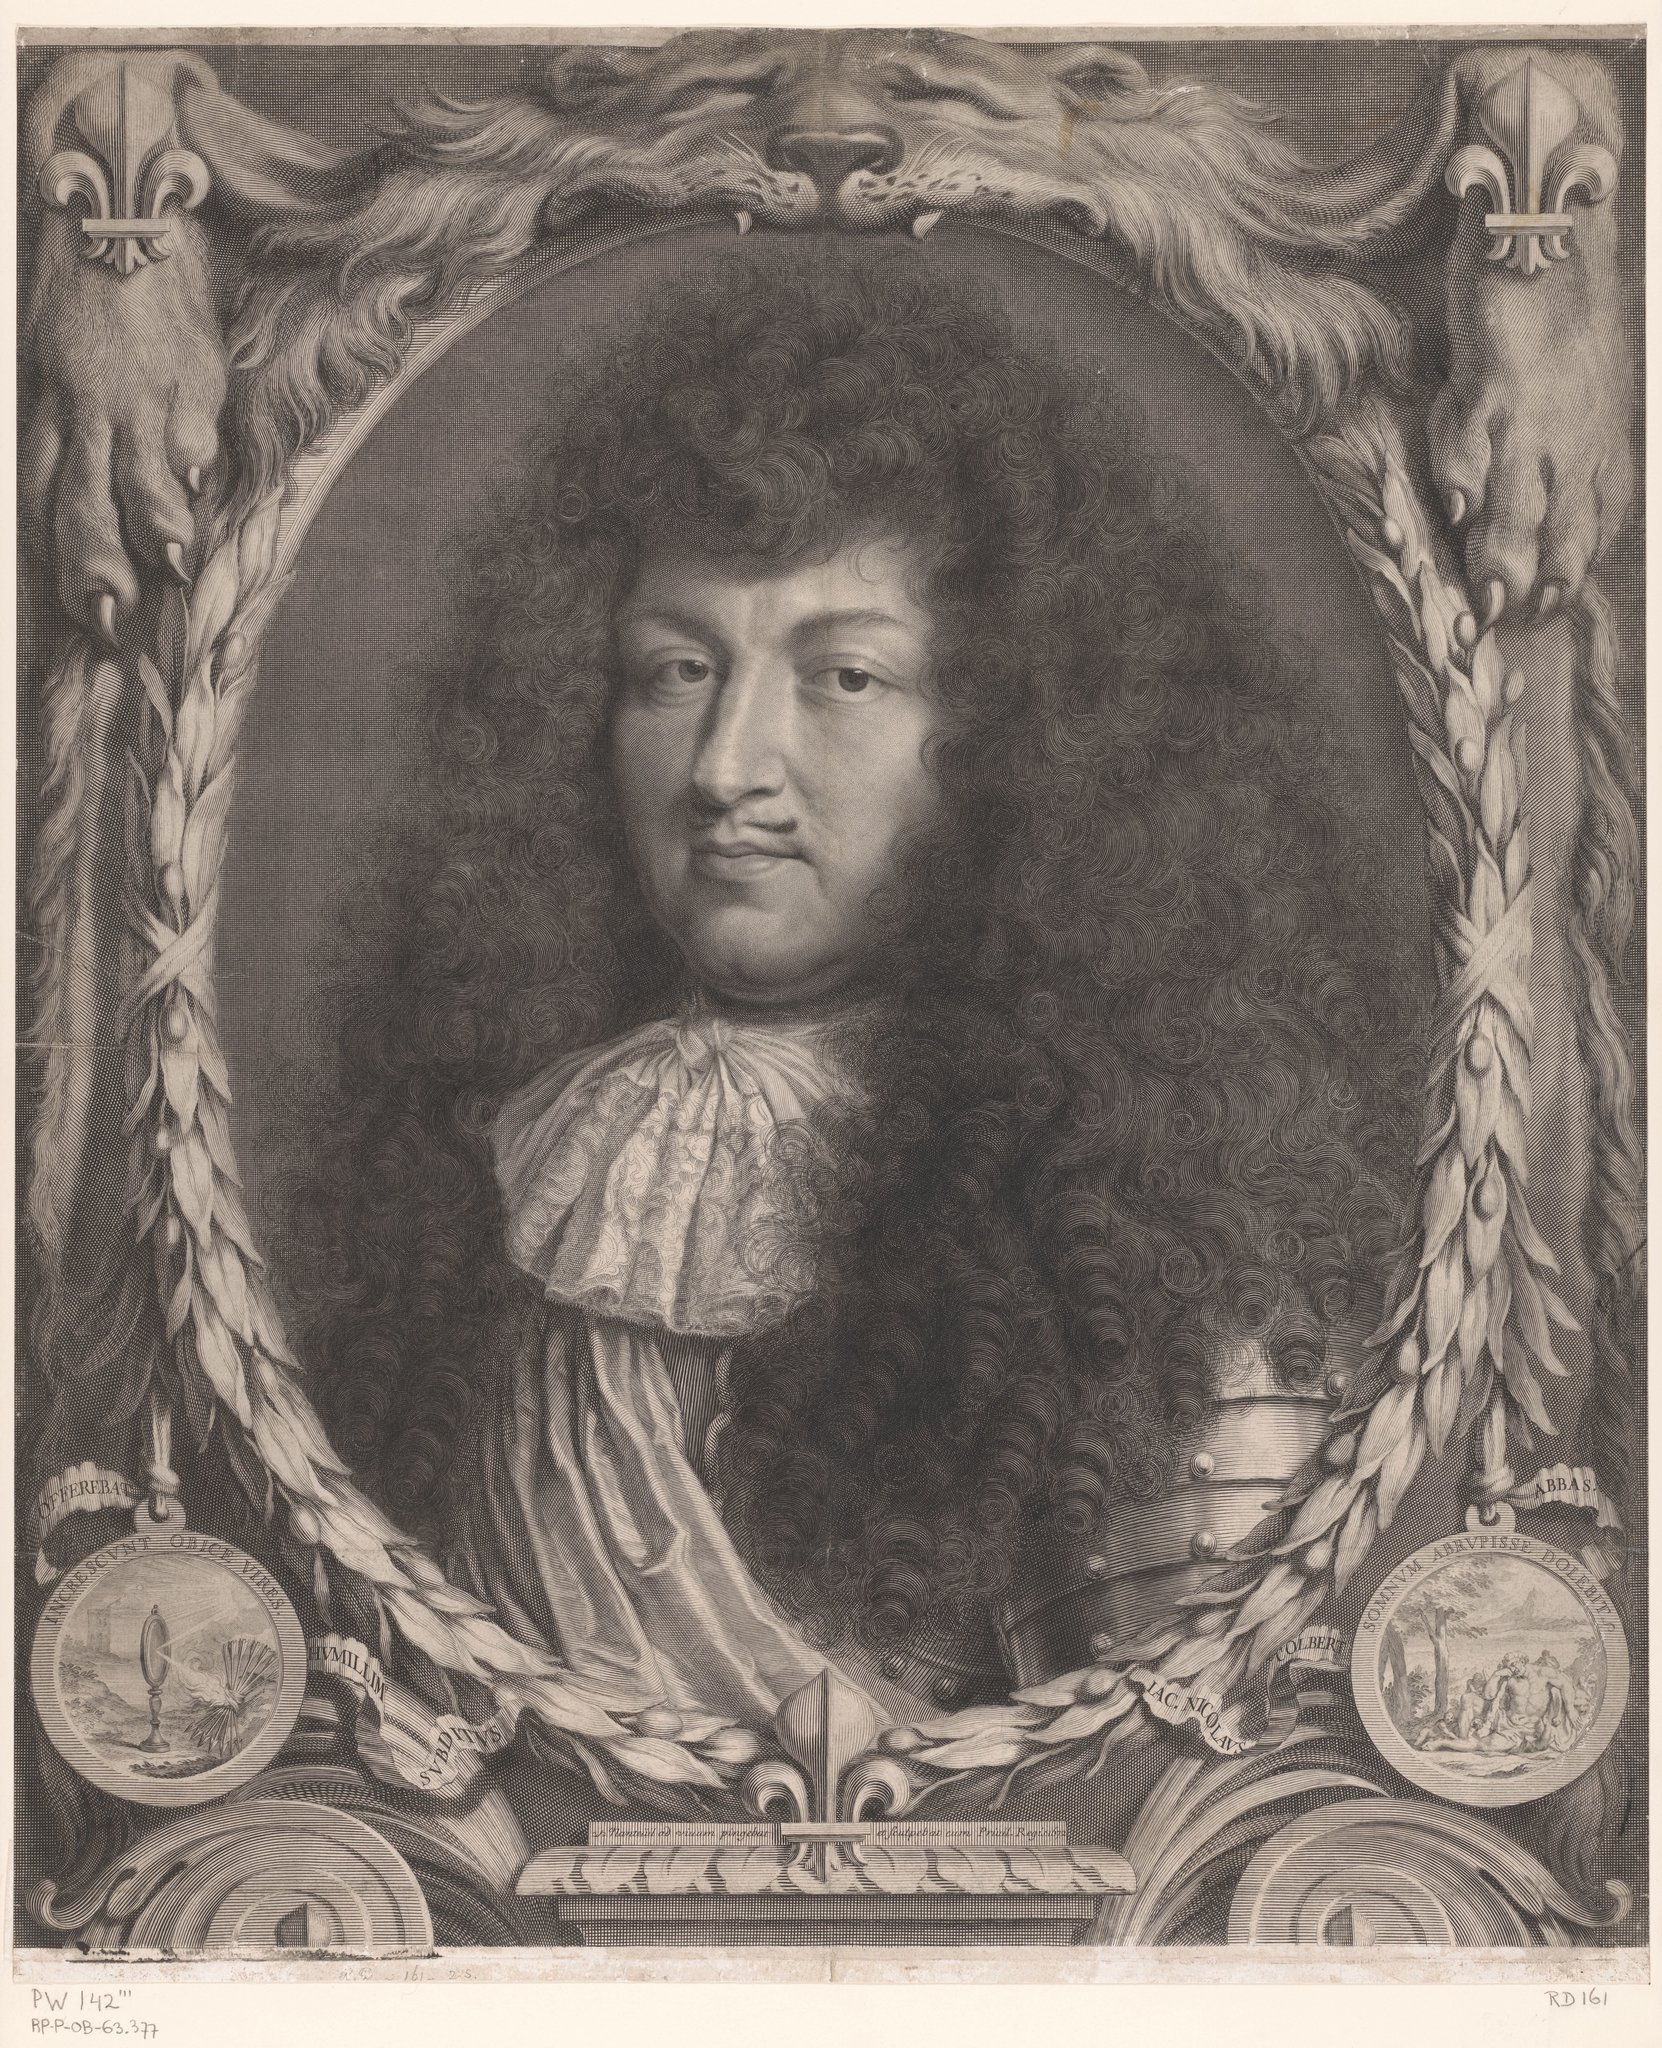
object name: print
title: Portret van Lodewijk XIV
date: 1672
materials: paper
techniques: engraving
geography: france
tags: lodewijk xiv (koning van frankrijk), attributes of hercules, historical persons, king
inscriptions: date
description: Portret van Lodewijk XIV, koning van Frankrijk, de haren lang tot op de schouders. In ovale lauwerkrans als omlijsting, waaroverheen een leeuwenhuid als draperie hangt. Links en rechtsonder een motto in cirkel: links: INCRESCUNT OBICE VIRES: een vuur ontstaat door de weerkaatsing van de zon in een vergrootglas; rechts: SOMNIUM ABRUPISSEDOLEBIT: Hercules rustend.